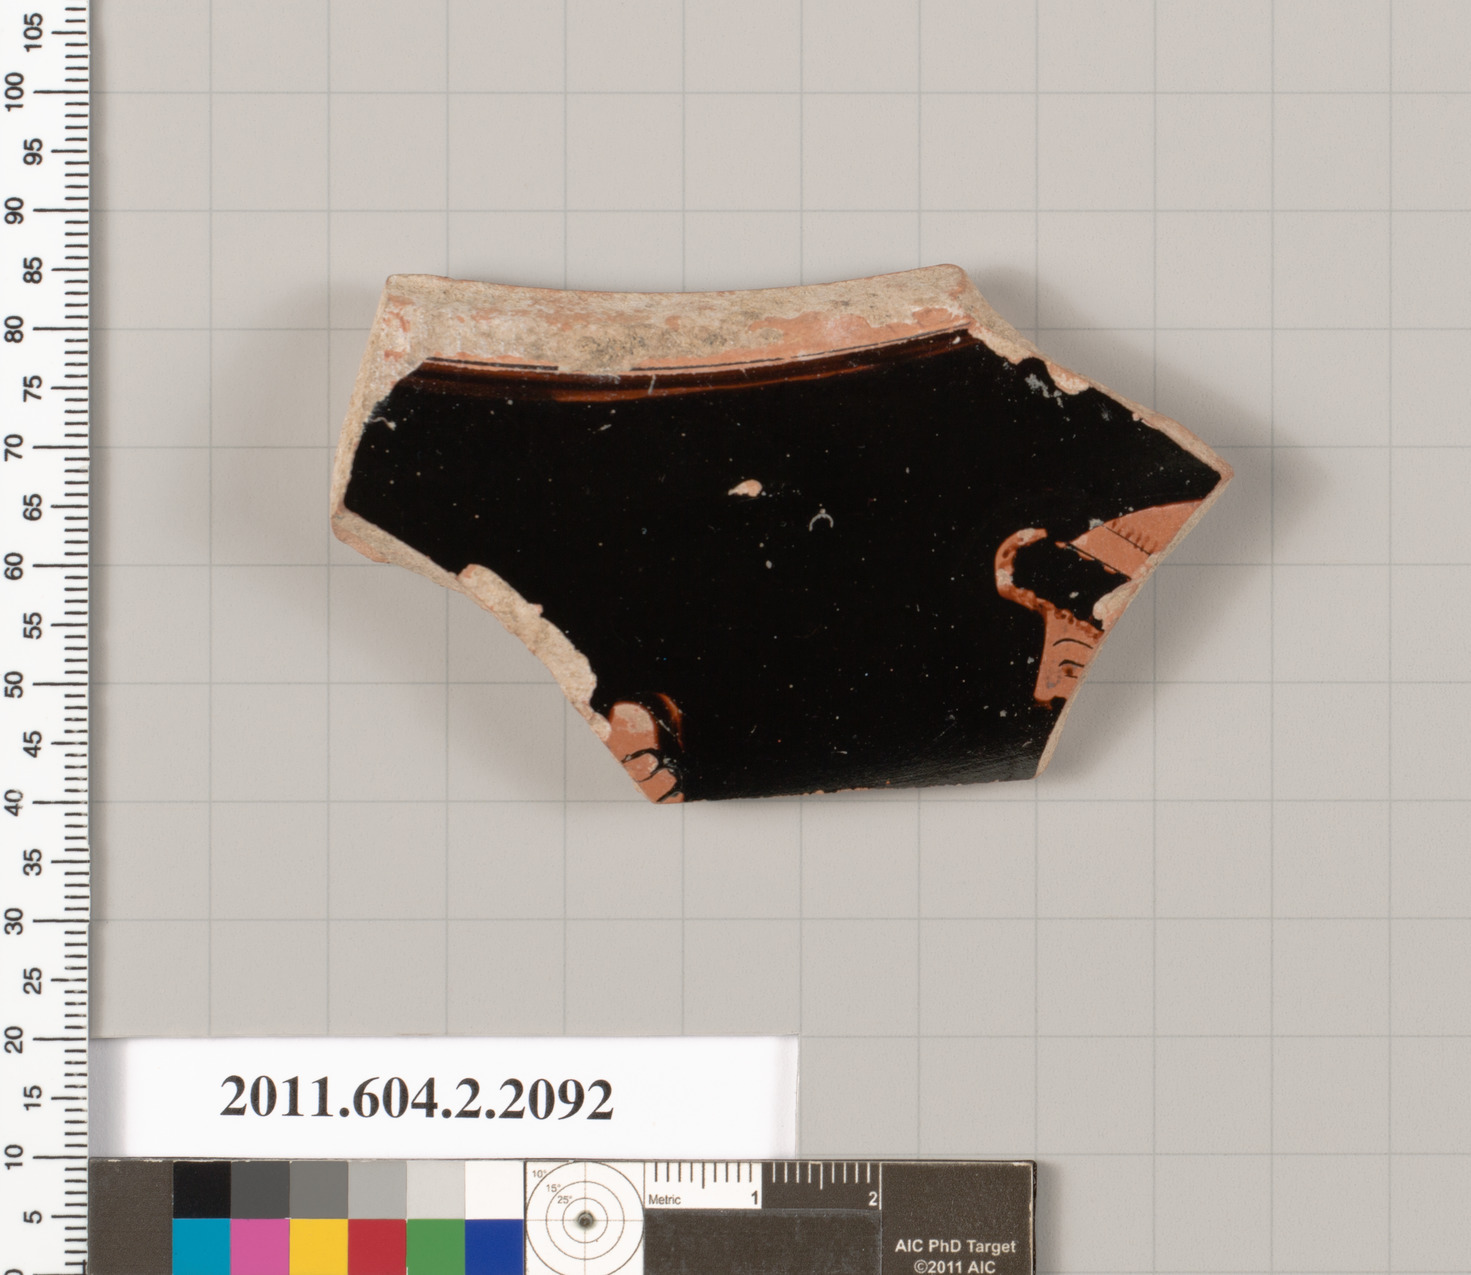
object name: stamnos fragment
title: Terracotta fragment of a stamnos (jar)?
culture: greek, attic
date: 475-451 BCE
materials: terracotta